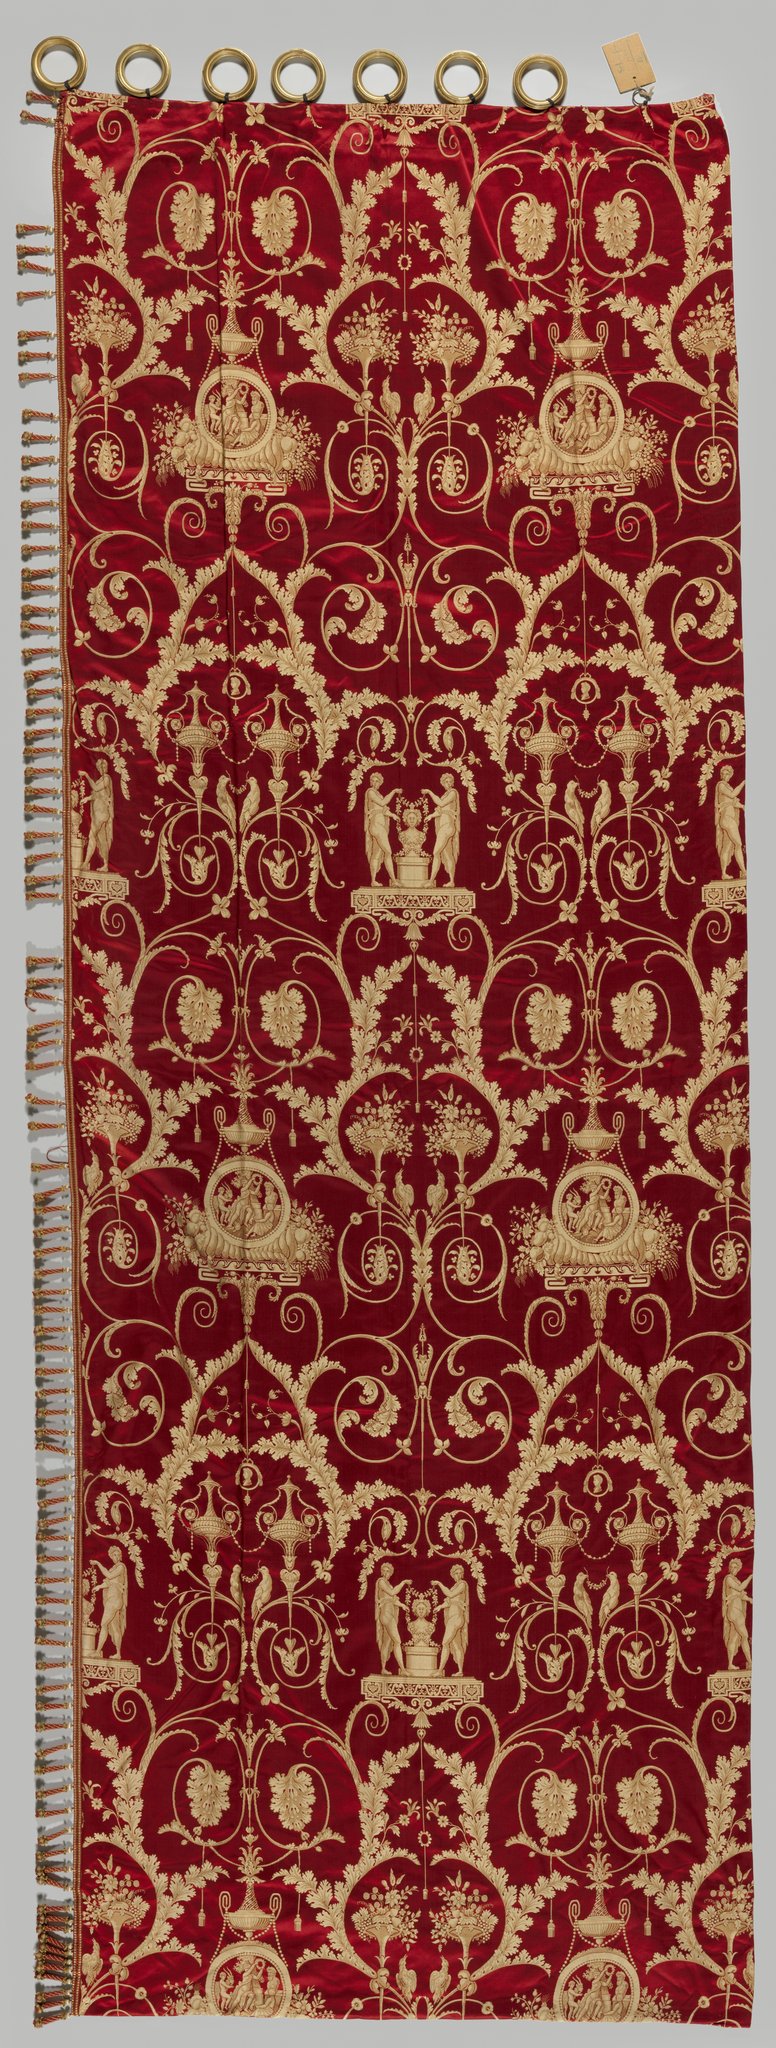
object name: curtain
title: Gordijn met imitatiestijl Directoire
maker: Anonymous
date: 1800-1825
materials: brass, cotton, textile, silk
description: Gordijn met groteskenpatroon van medaillons, portretbustes, vazen en voluutranken in crème tegen een satijnen ondergrond in donker steenrood. Neo-Pompeiaans. Rode voering. Met grote, geprofileerde ringen en franjes langs één kant.